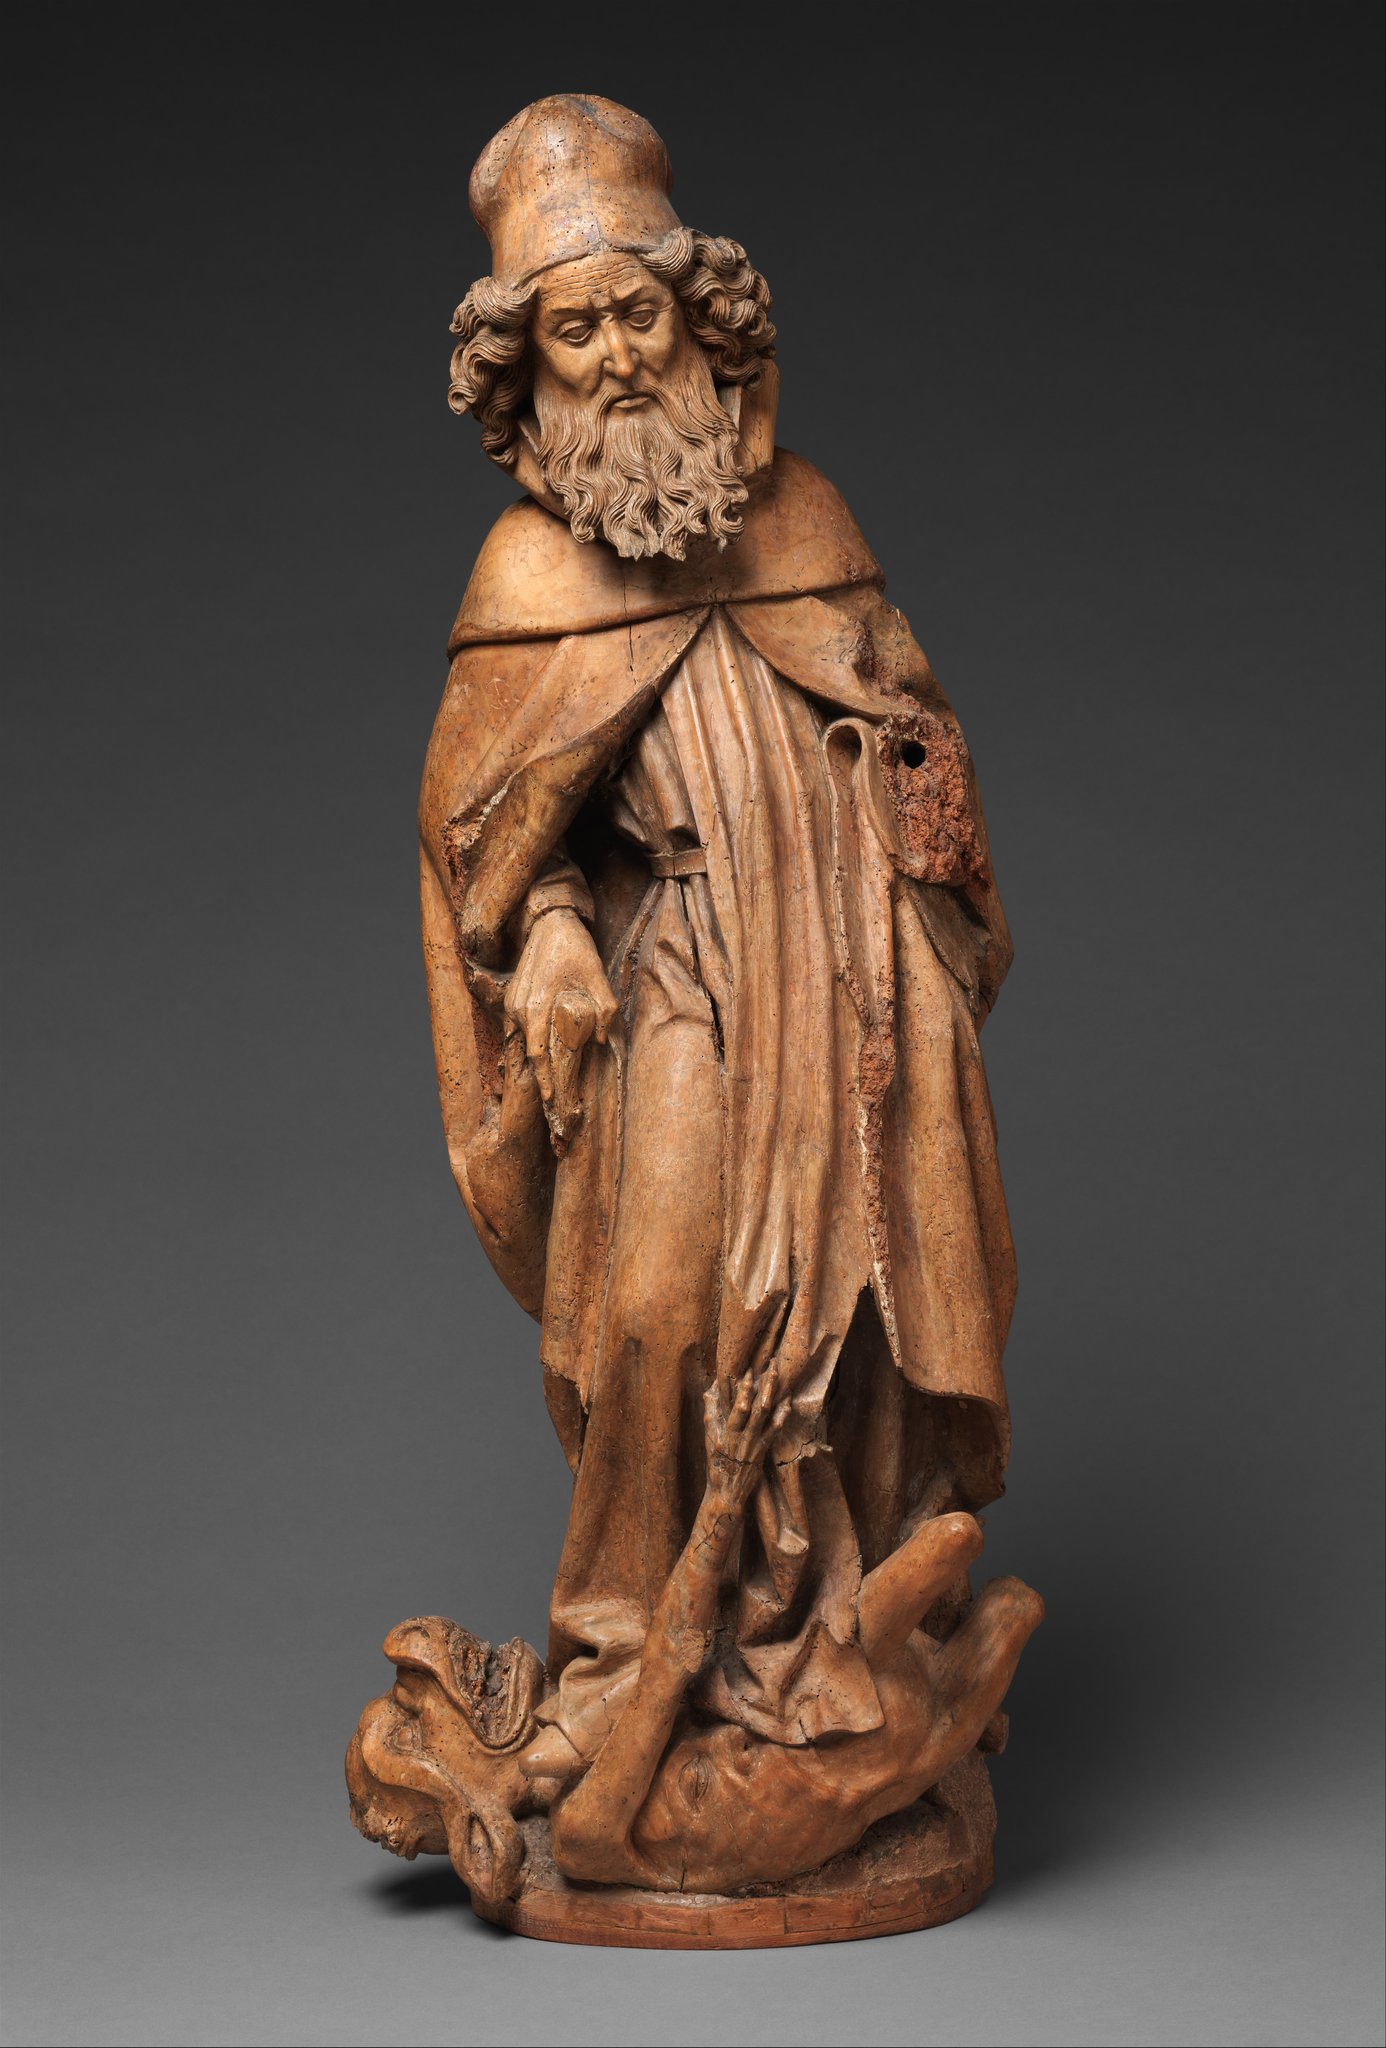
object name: statue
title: Saint Anthony Abbot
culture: german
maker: nikolaus von hagenau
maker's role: artist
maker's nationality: german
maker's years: 1445-1538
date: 1500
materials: wood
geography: france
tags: men,demons,saints